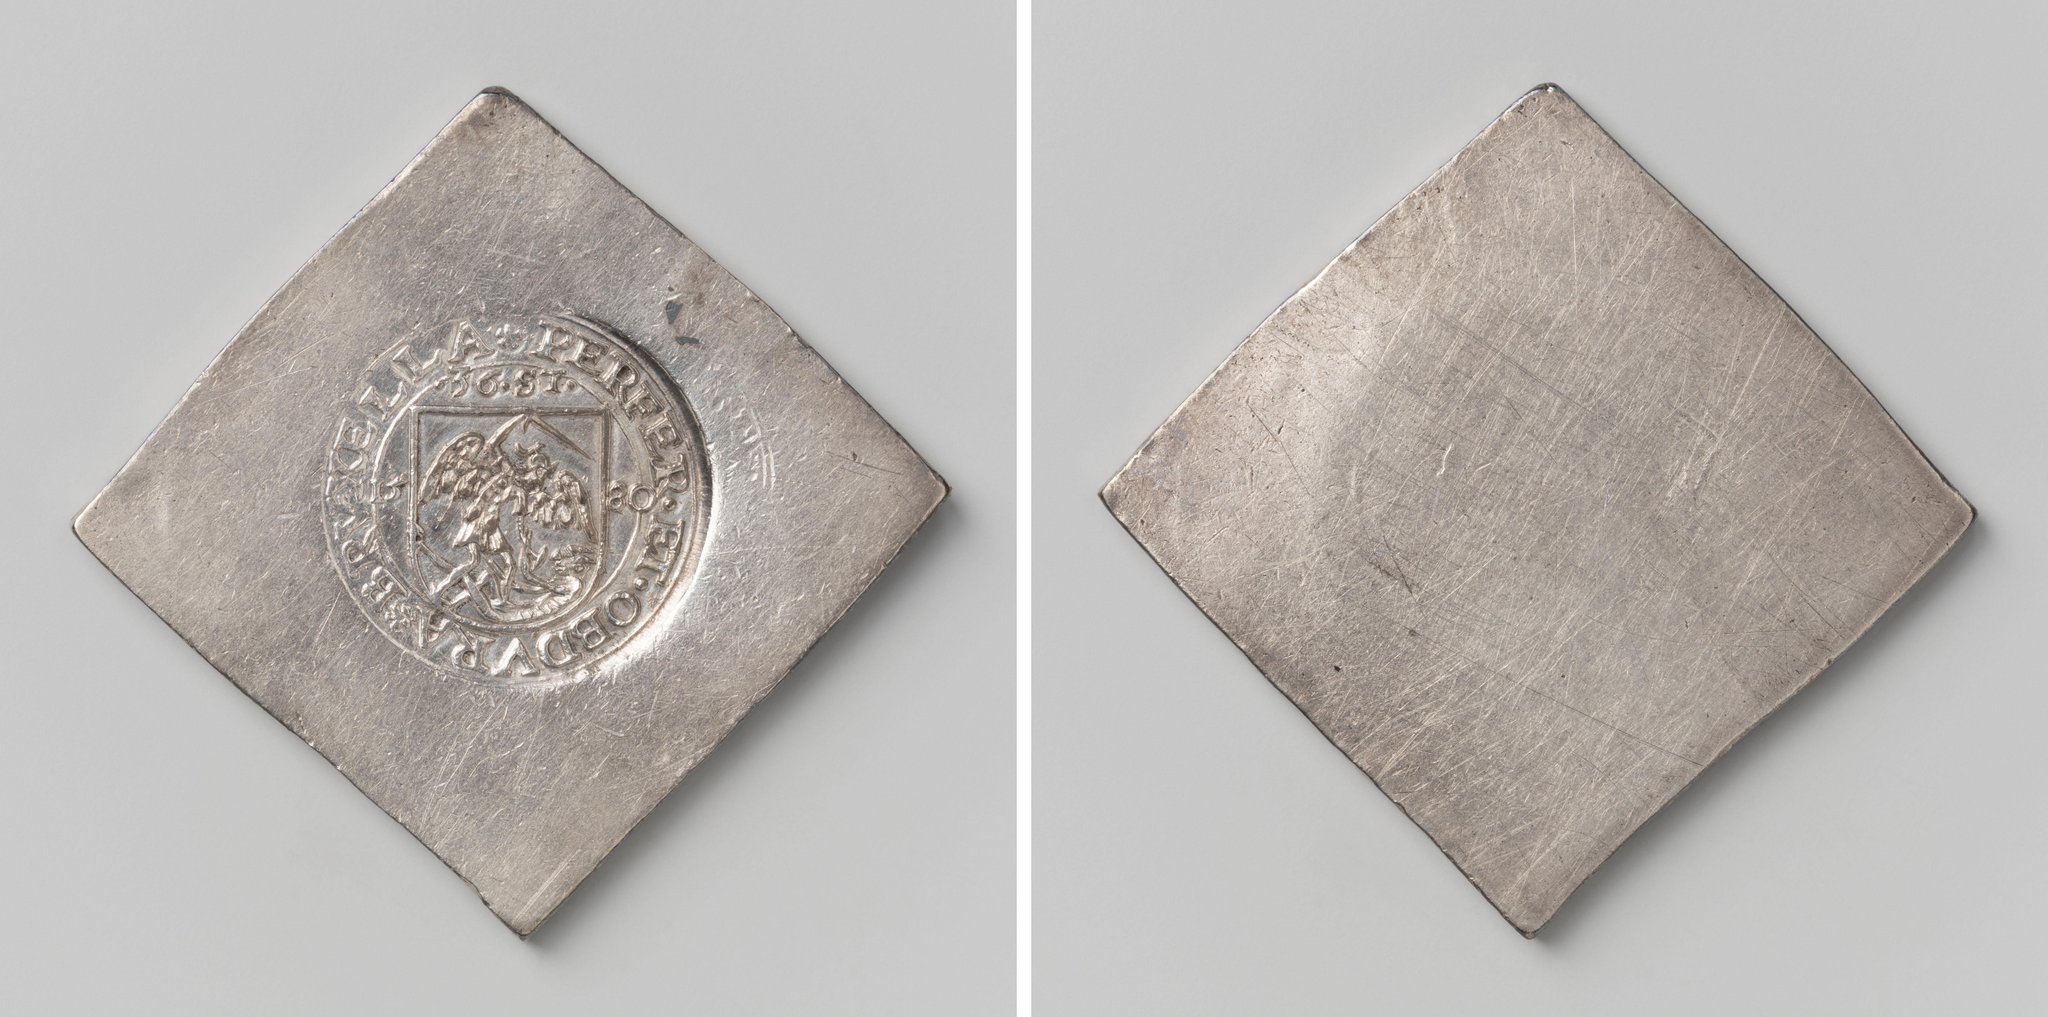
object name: siege coin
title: Zesendertig stuiver, noodmunt uit Brussel, door de Spaanse troepen afgesneden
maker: Anonymous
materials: silver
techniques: striking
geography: brussels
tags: brussels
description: Eenzijdige zilveren ruitvormige noodmunt van Brussel. Voorzijde: een ronde stempel: wapenschild onder waardeaanduiding, tussen jaartal binnen omschrift. Keerzijde: blanco.